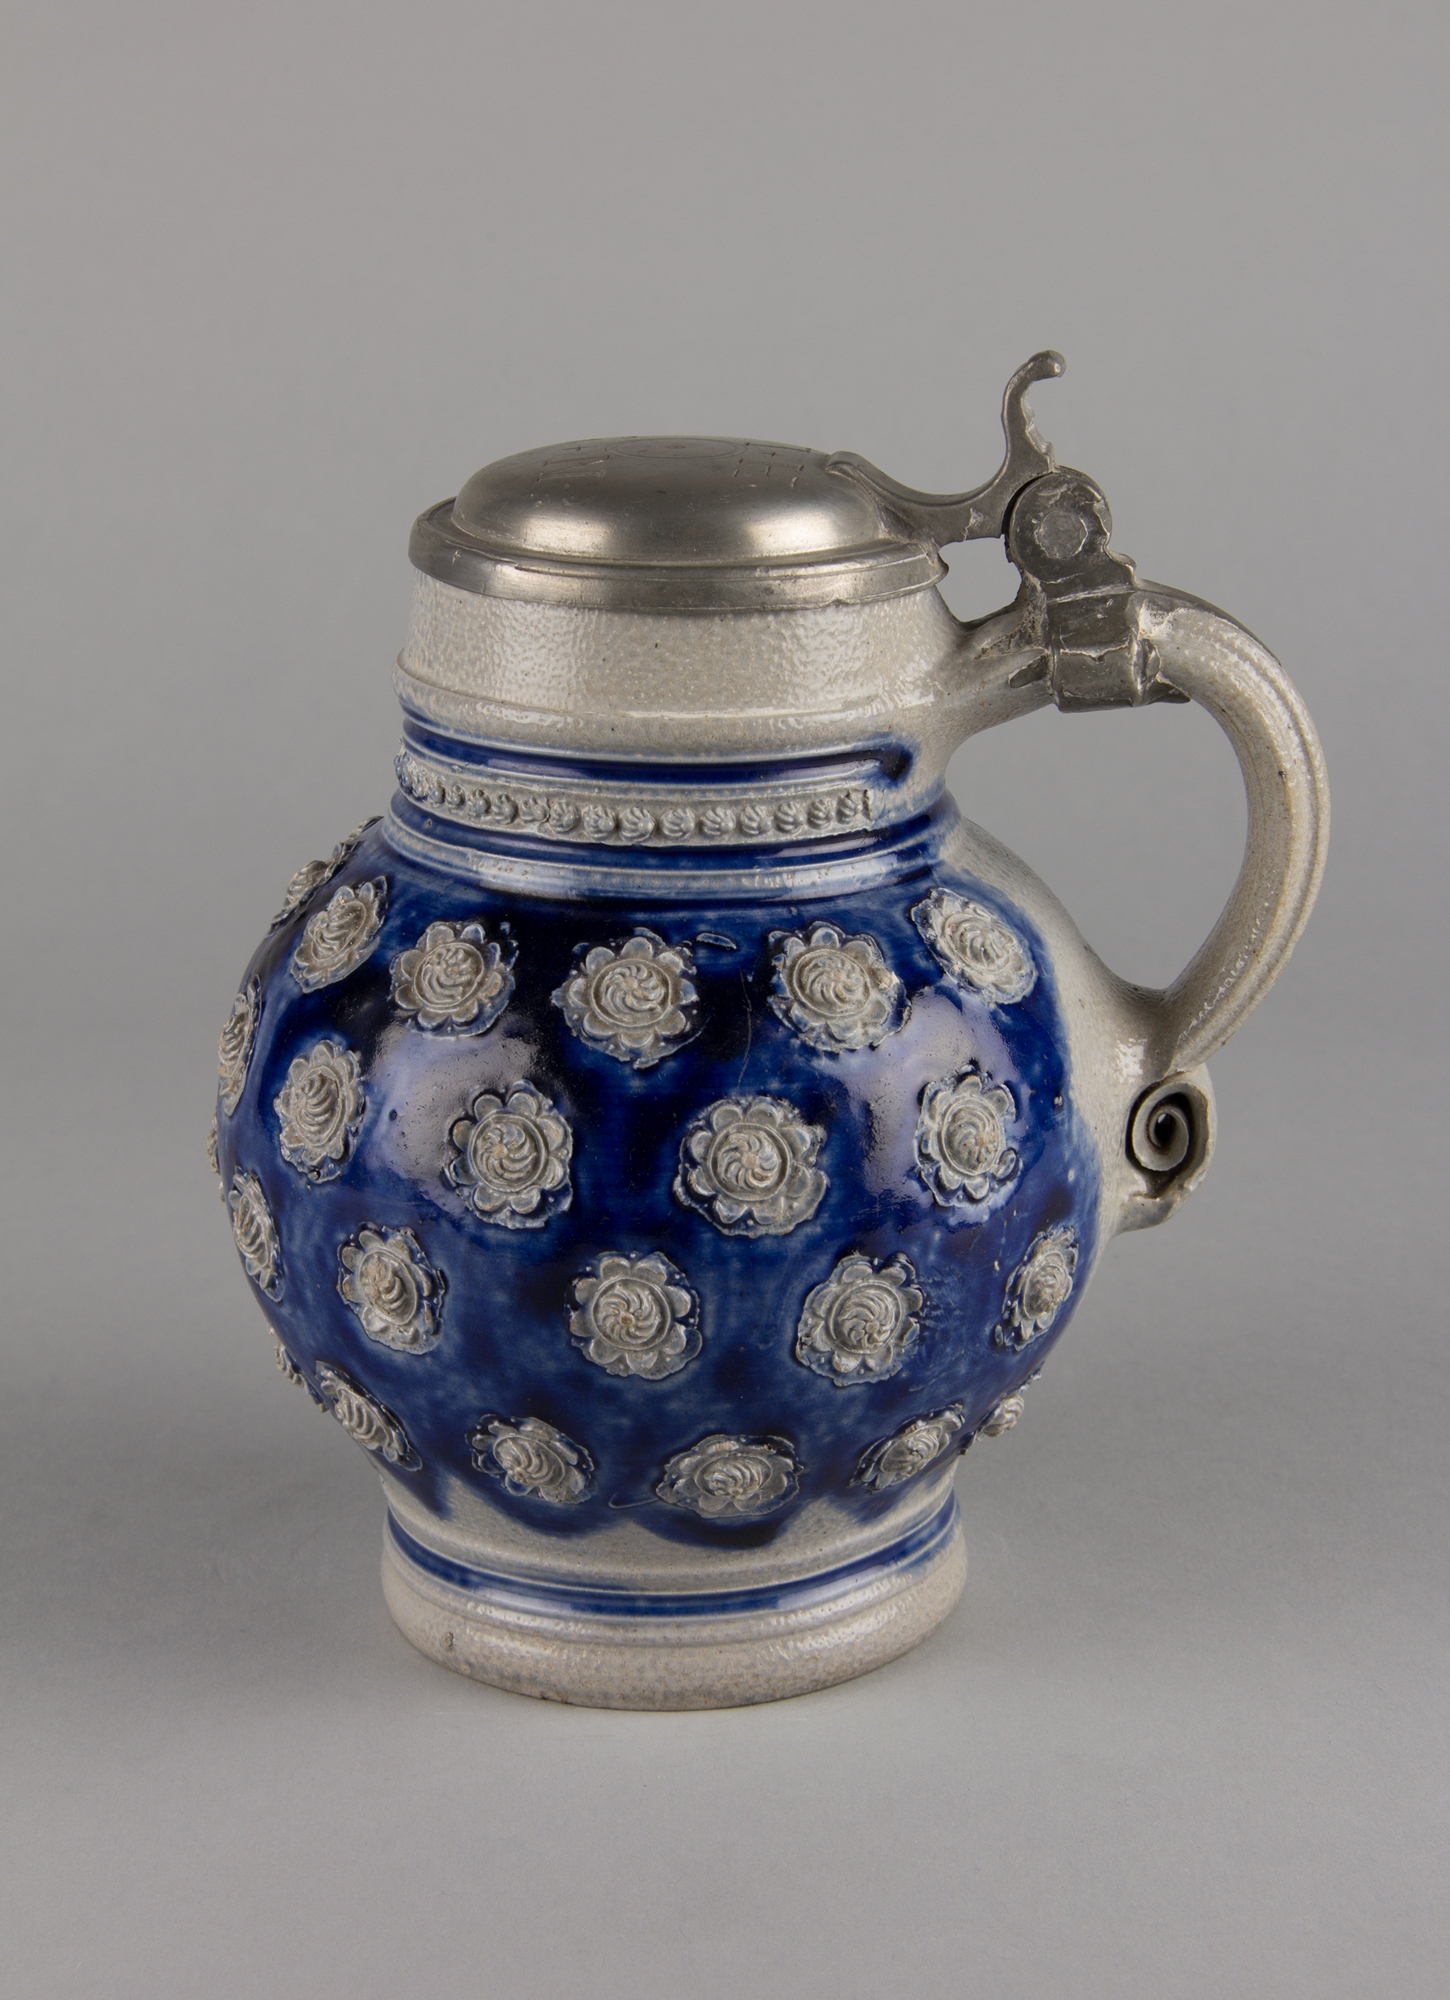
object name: mug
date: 1634-1666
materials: stoneware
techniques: underglaze